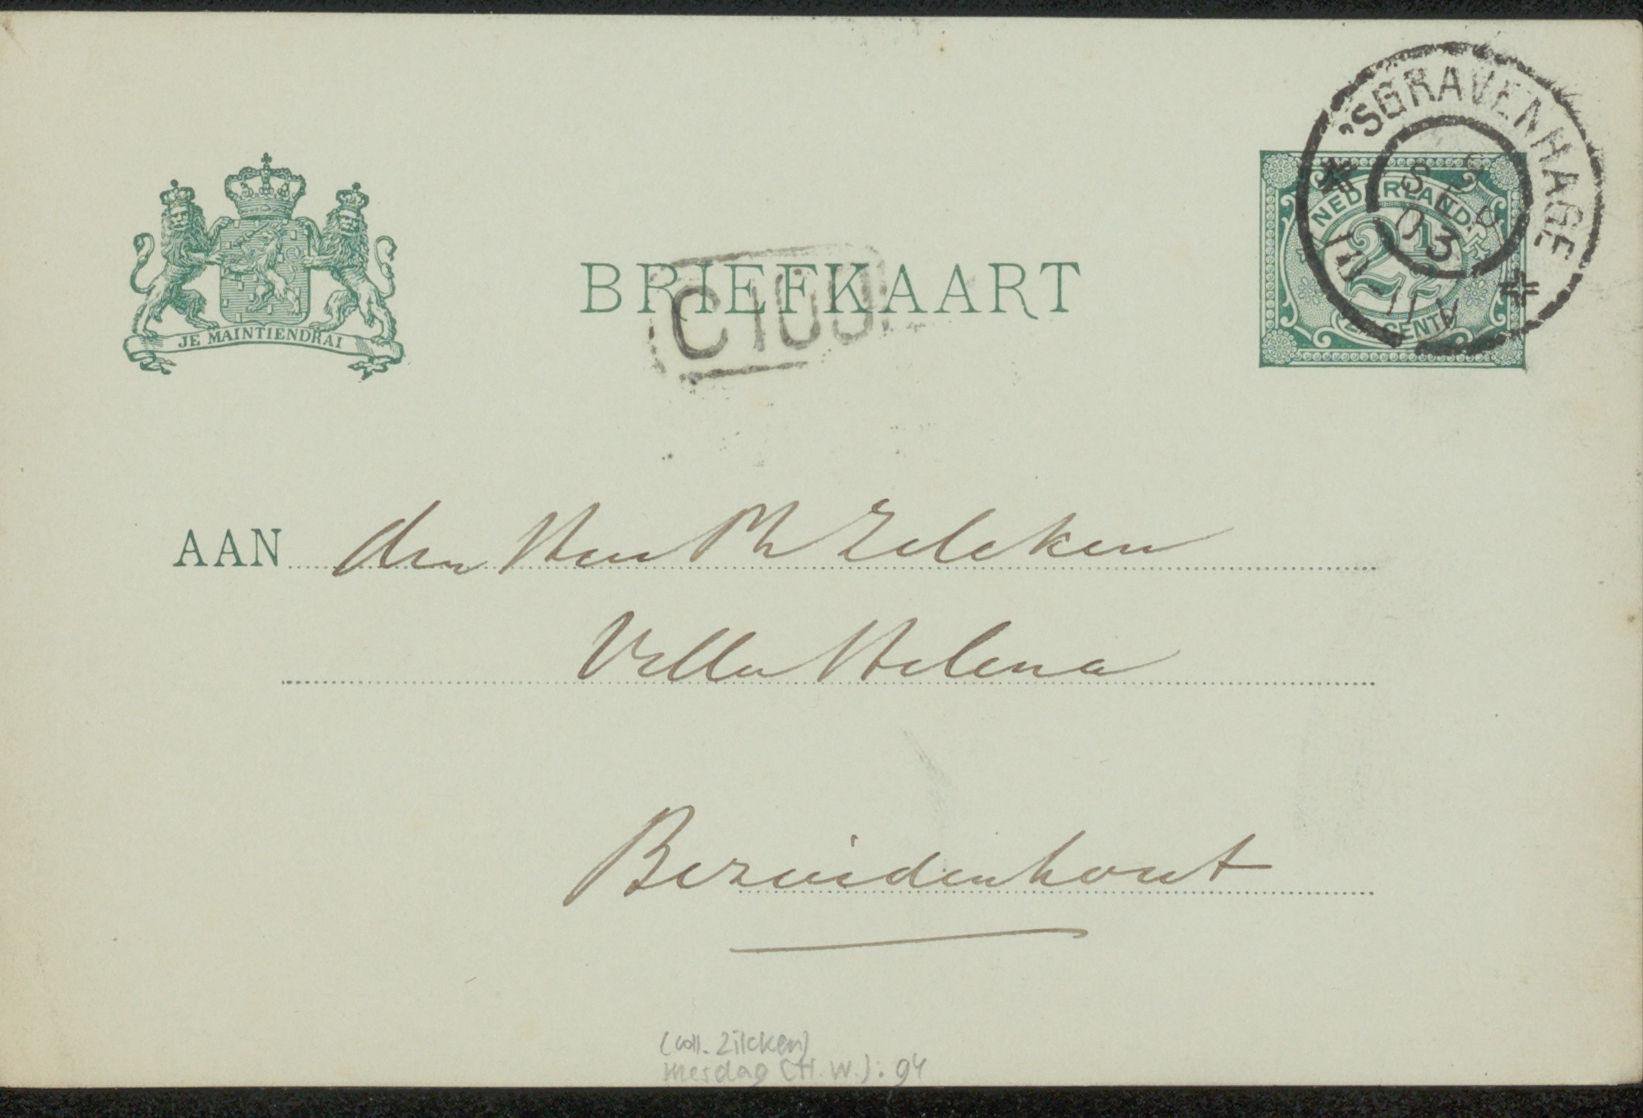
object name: postcard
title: Briefkaart aan Philip Zilcken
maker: hendrik willem mesdag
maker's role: draughtsman, painter, print maker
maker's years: 1831-1915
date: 1903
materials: cardboard, ink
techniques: pen, writing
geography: the hague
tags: philip zilcken, exhibition ~ art